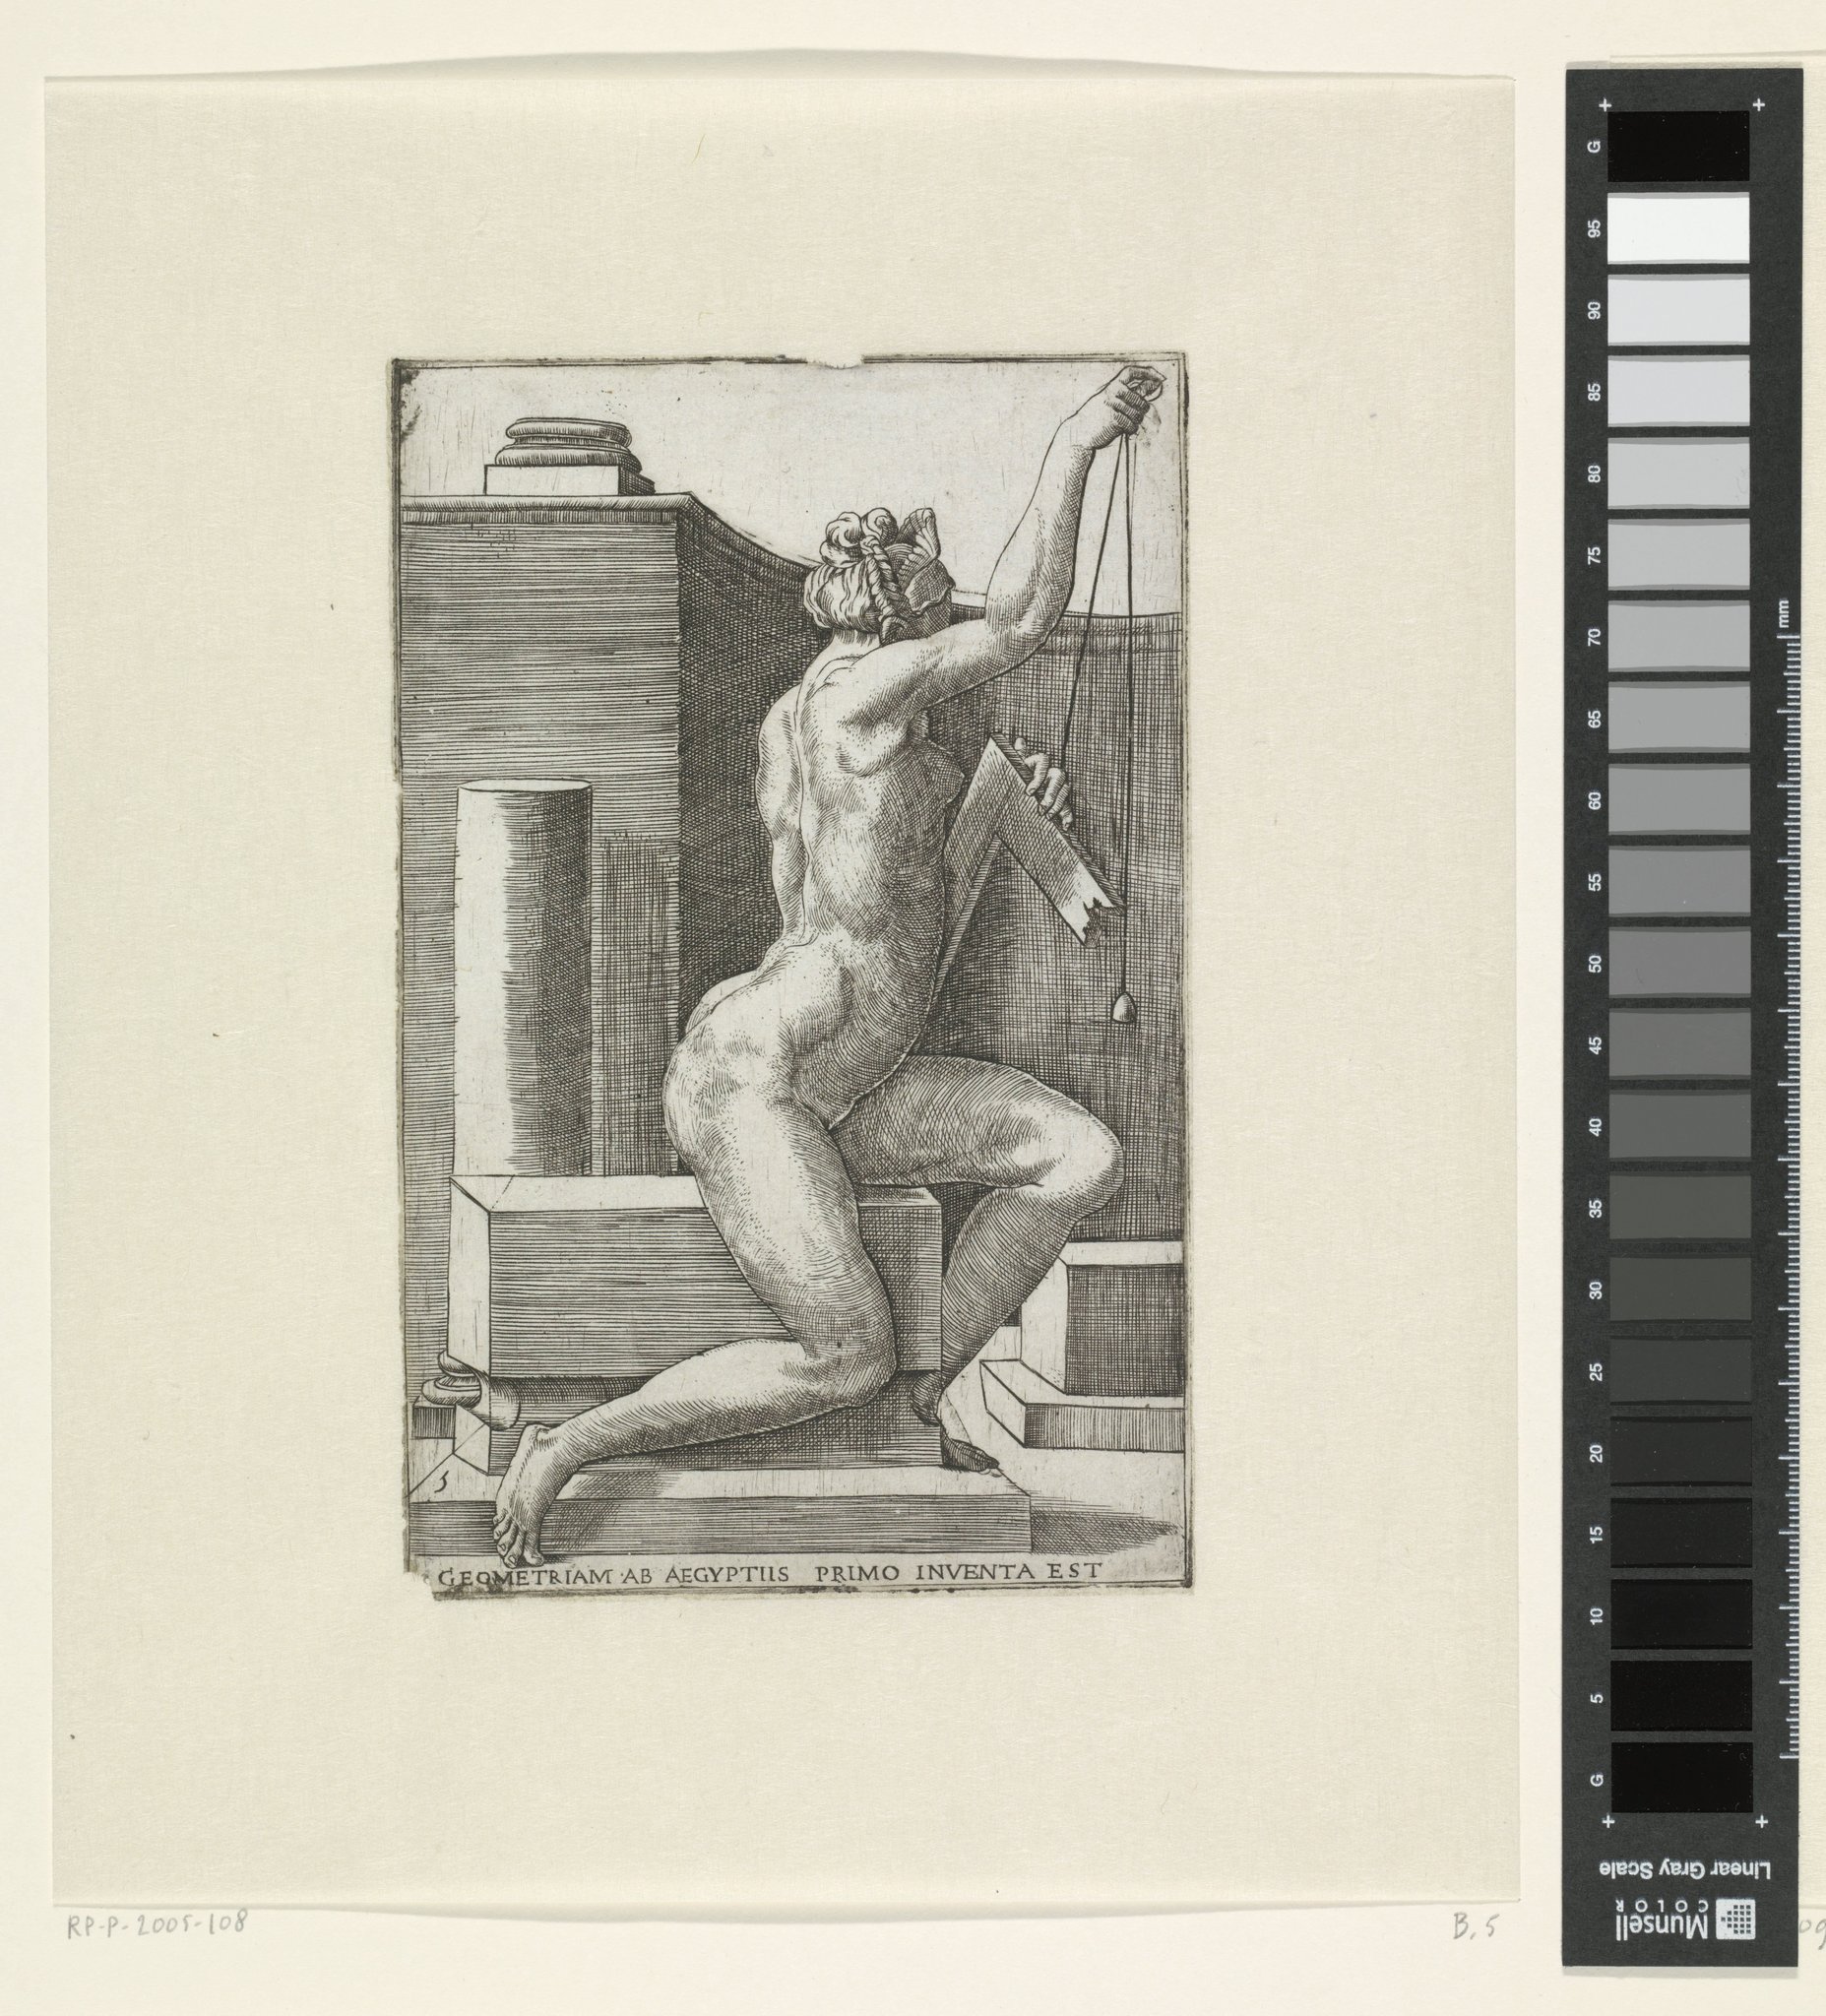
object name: print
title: Geometriam ab Aegyptus prima inventa est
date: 1544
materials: paper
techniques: engraving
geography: italy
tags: the liberal arts, 'artes liberales', 'geometria' (~ quadrivium); 'geometria' (ripa), measuring-instruments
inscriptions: collector's mark: Lugt 2760, collector's mark: Lugt 2228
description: Personificatie van de meetkunde (Geometria). Een naakte vrouw, zittend, naar rechts, met schietlood en winkelhaak in de handen. Achter haar een stenen halfronde muur, een sokkel en een halve zuil.